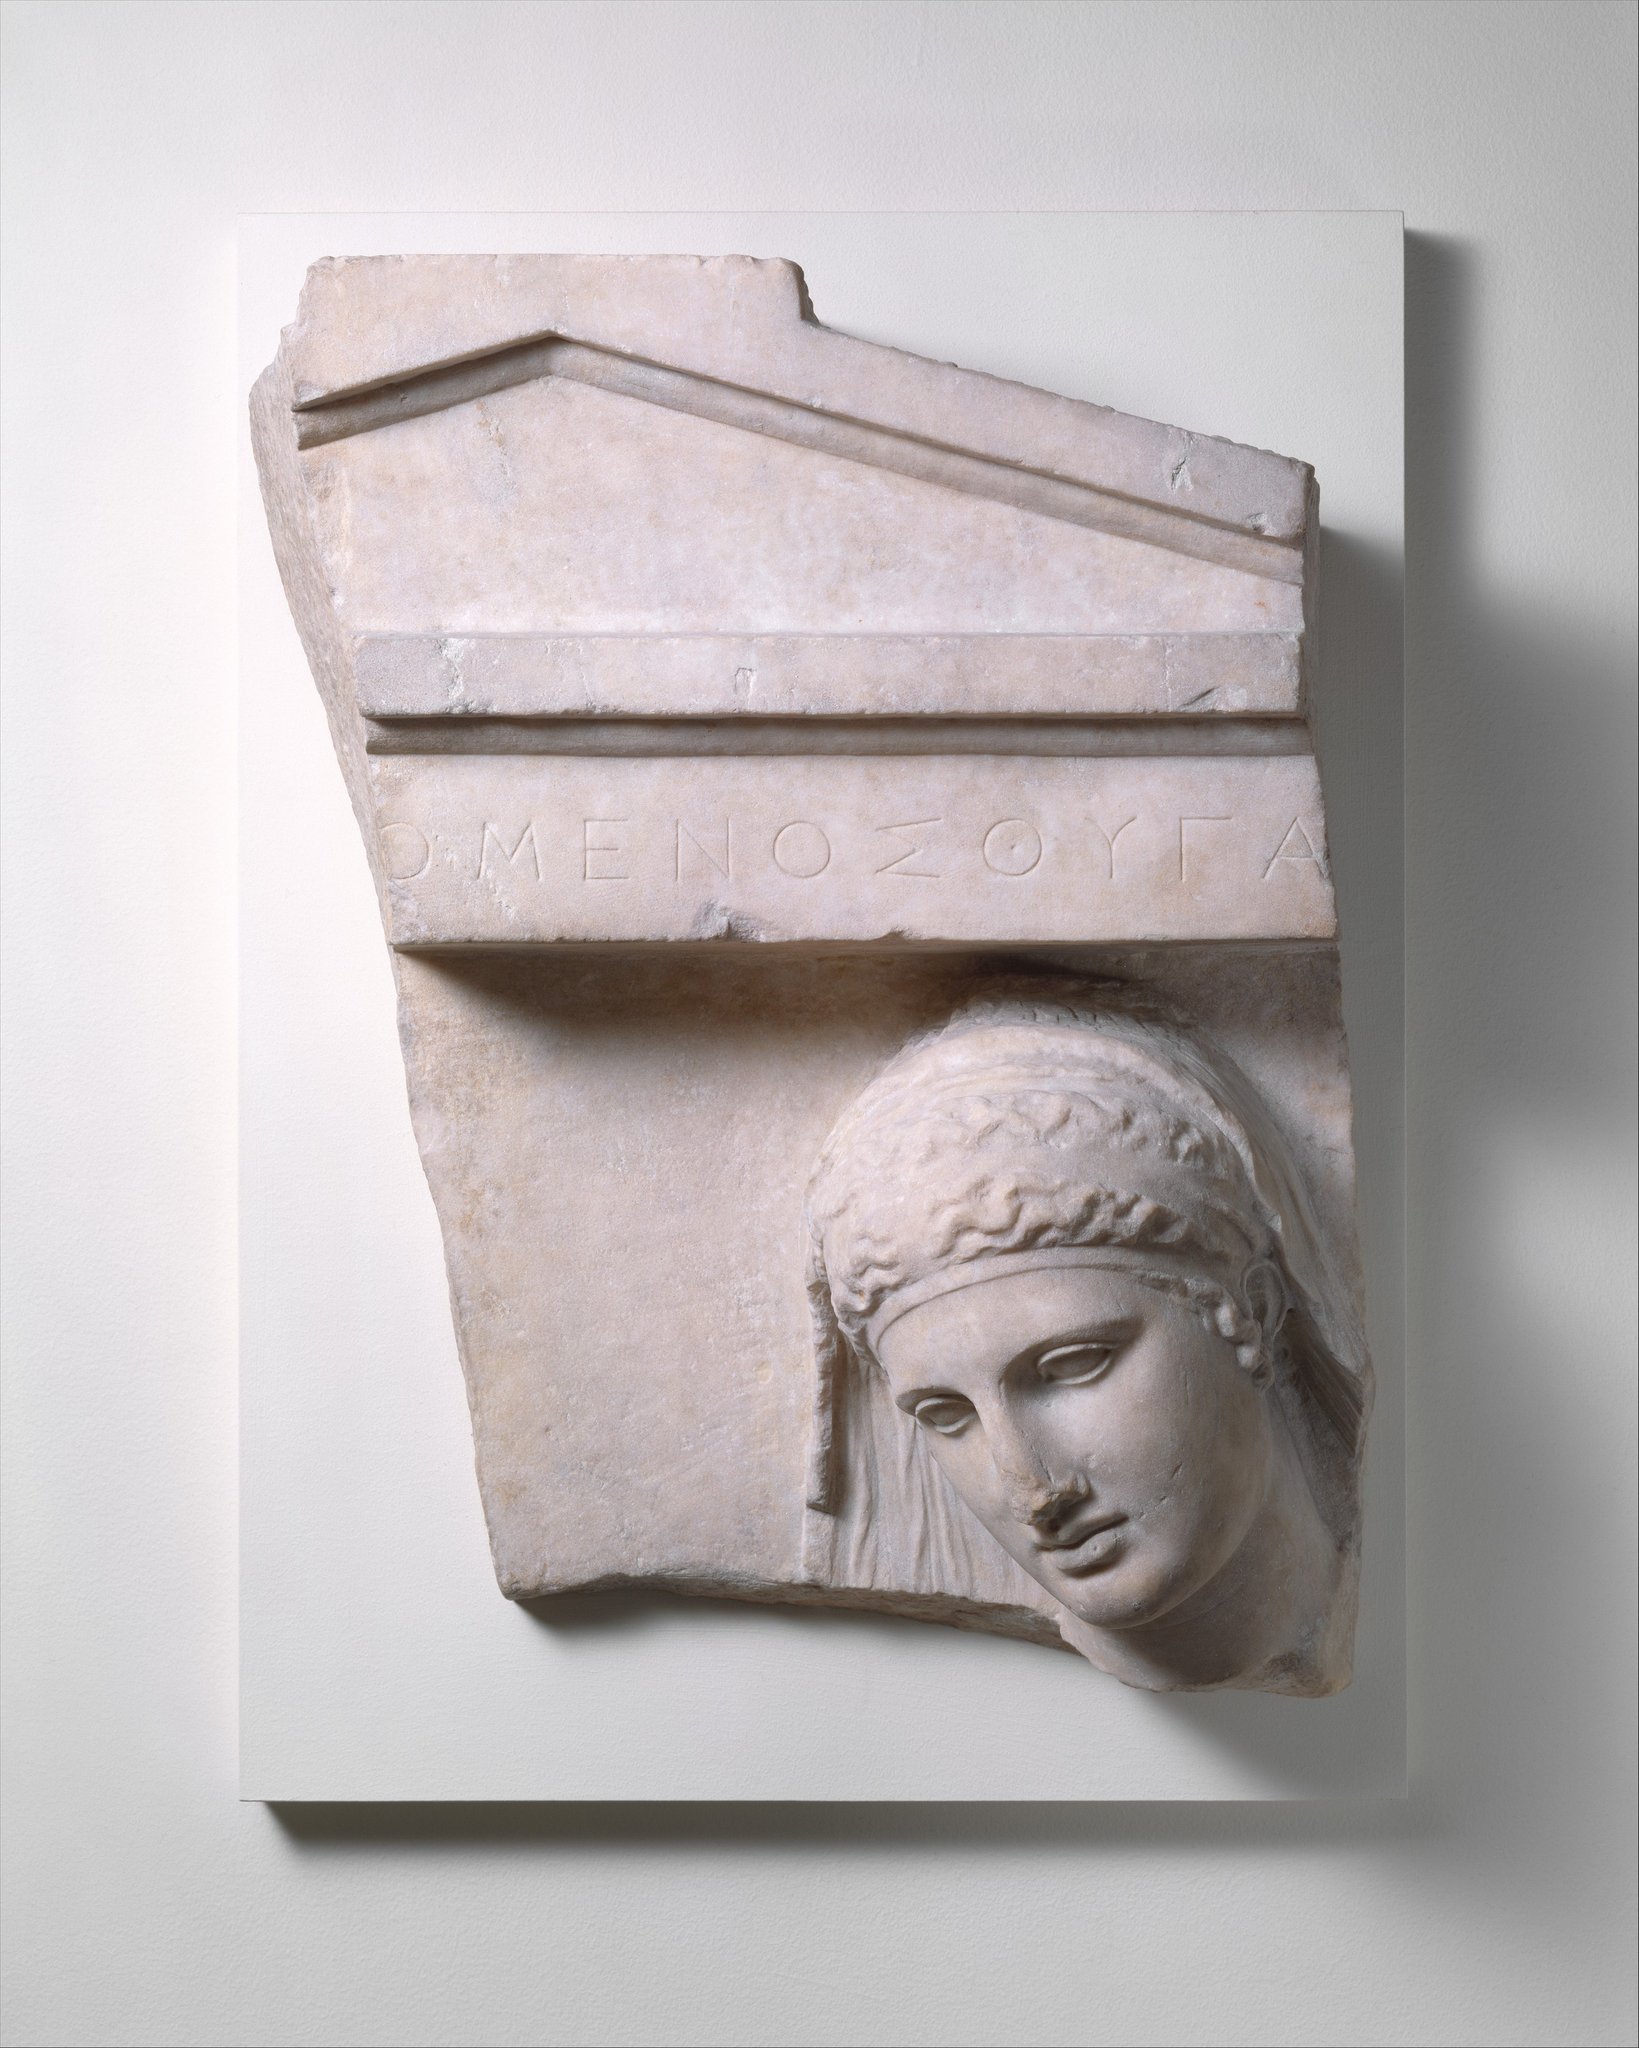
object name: grave stele of a woman, fragment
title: Fragment of a marble grave stele of a woman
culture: greek, attic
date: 400-390 BCE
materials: marble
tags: heads,women